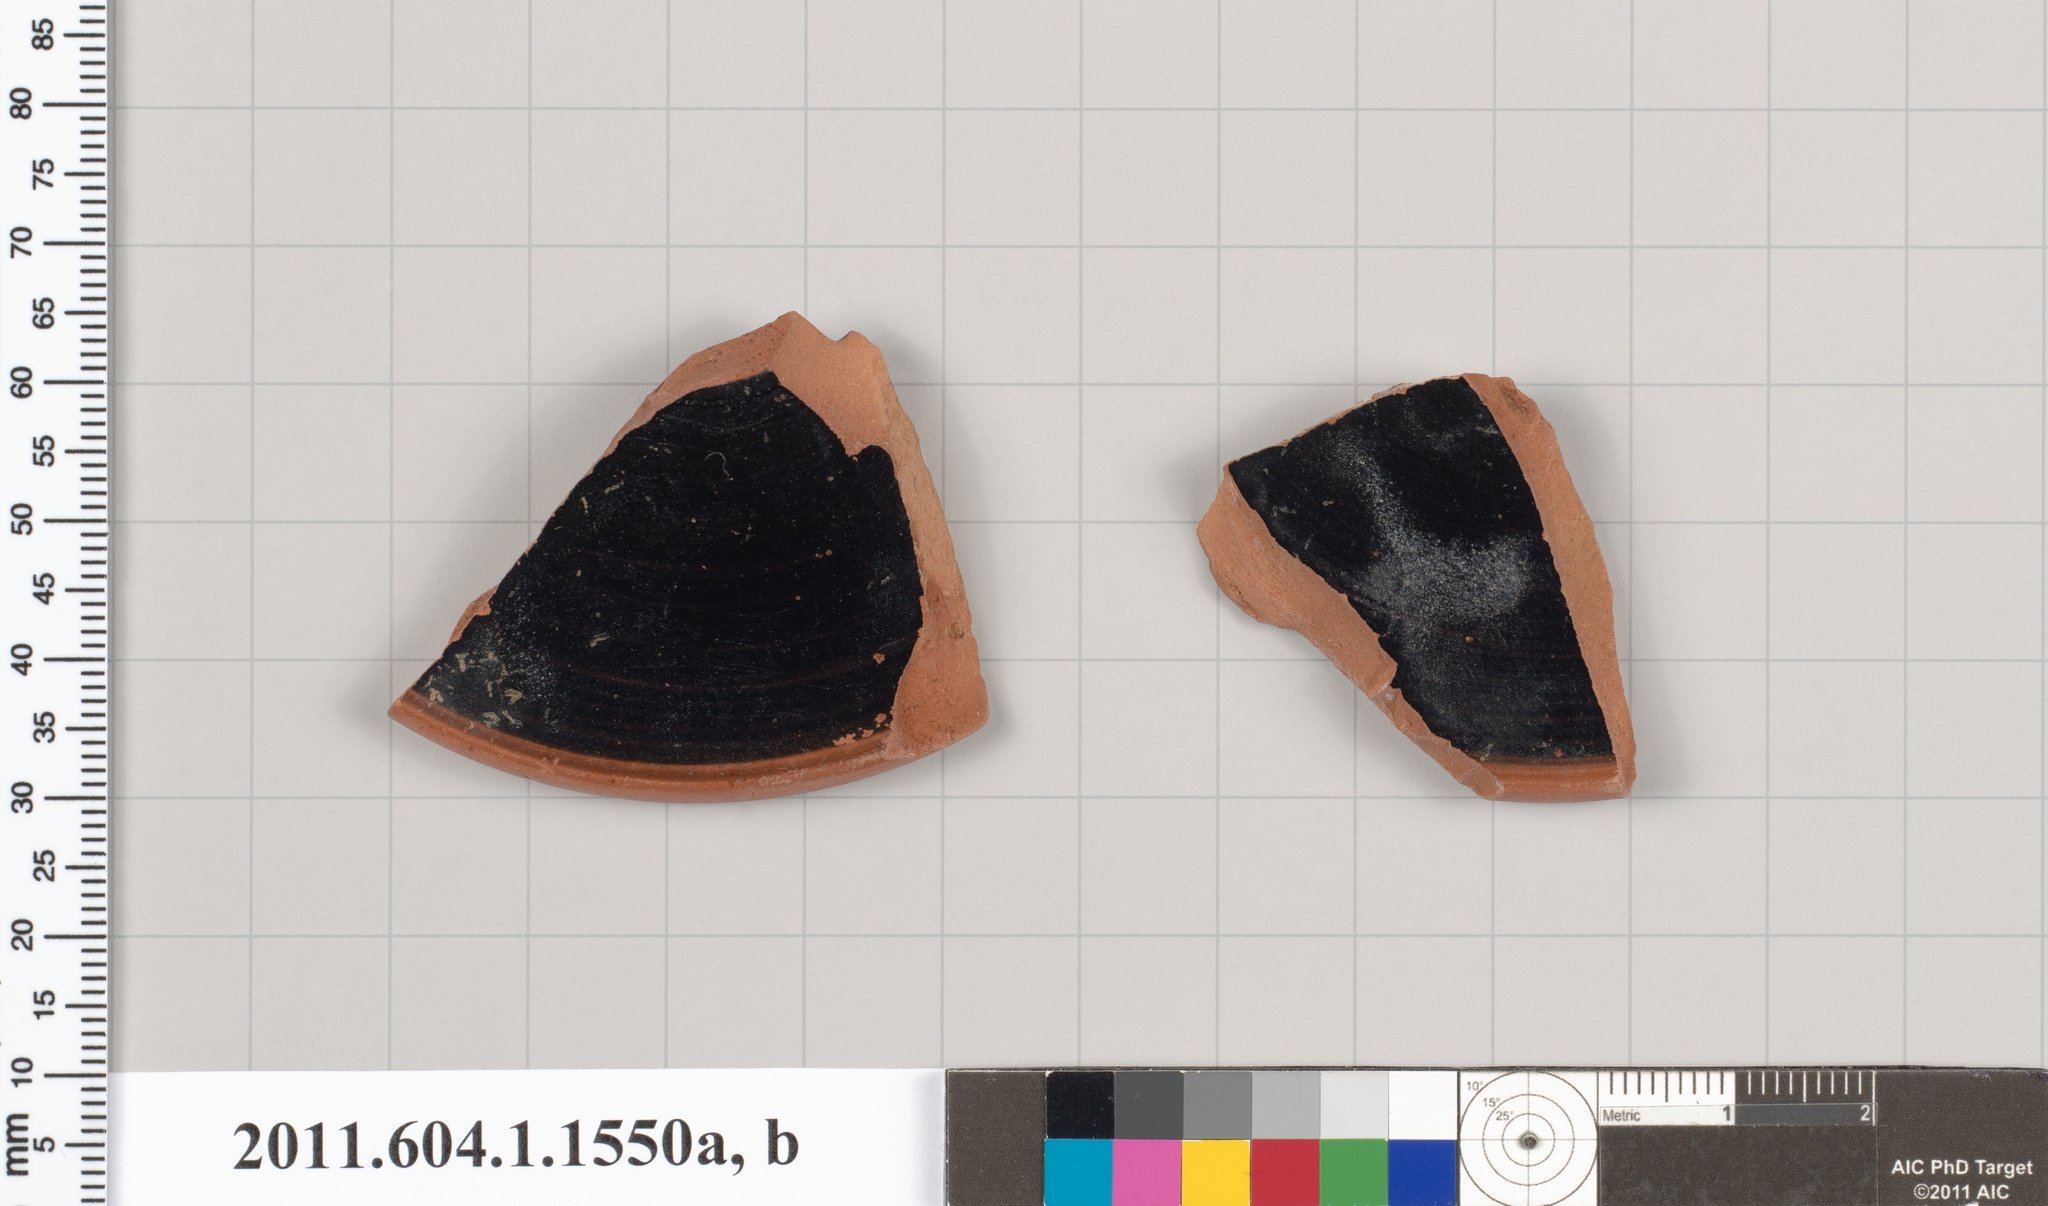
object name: kylix fragment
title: Terracotta fragments of kylikes (drinking cups)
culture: greek, attic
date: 500-401 BCE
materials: terracotta